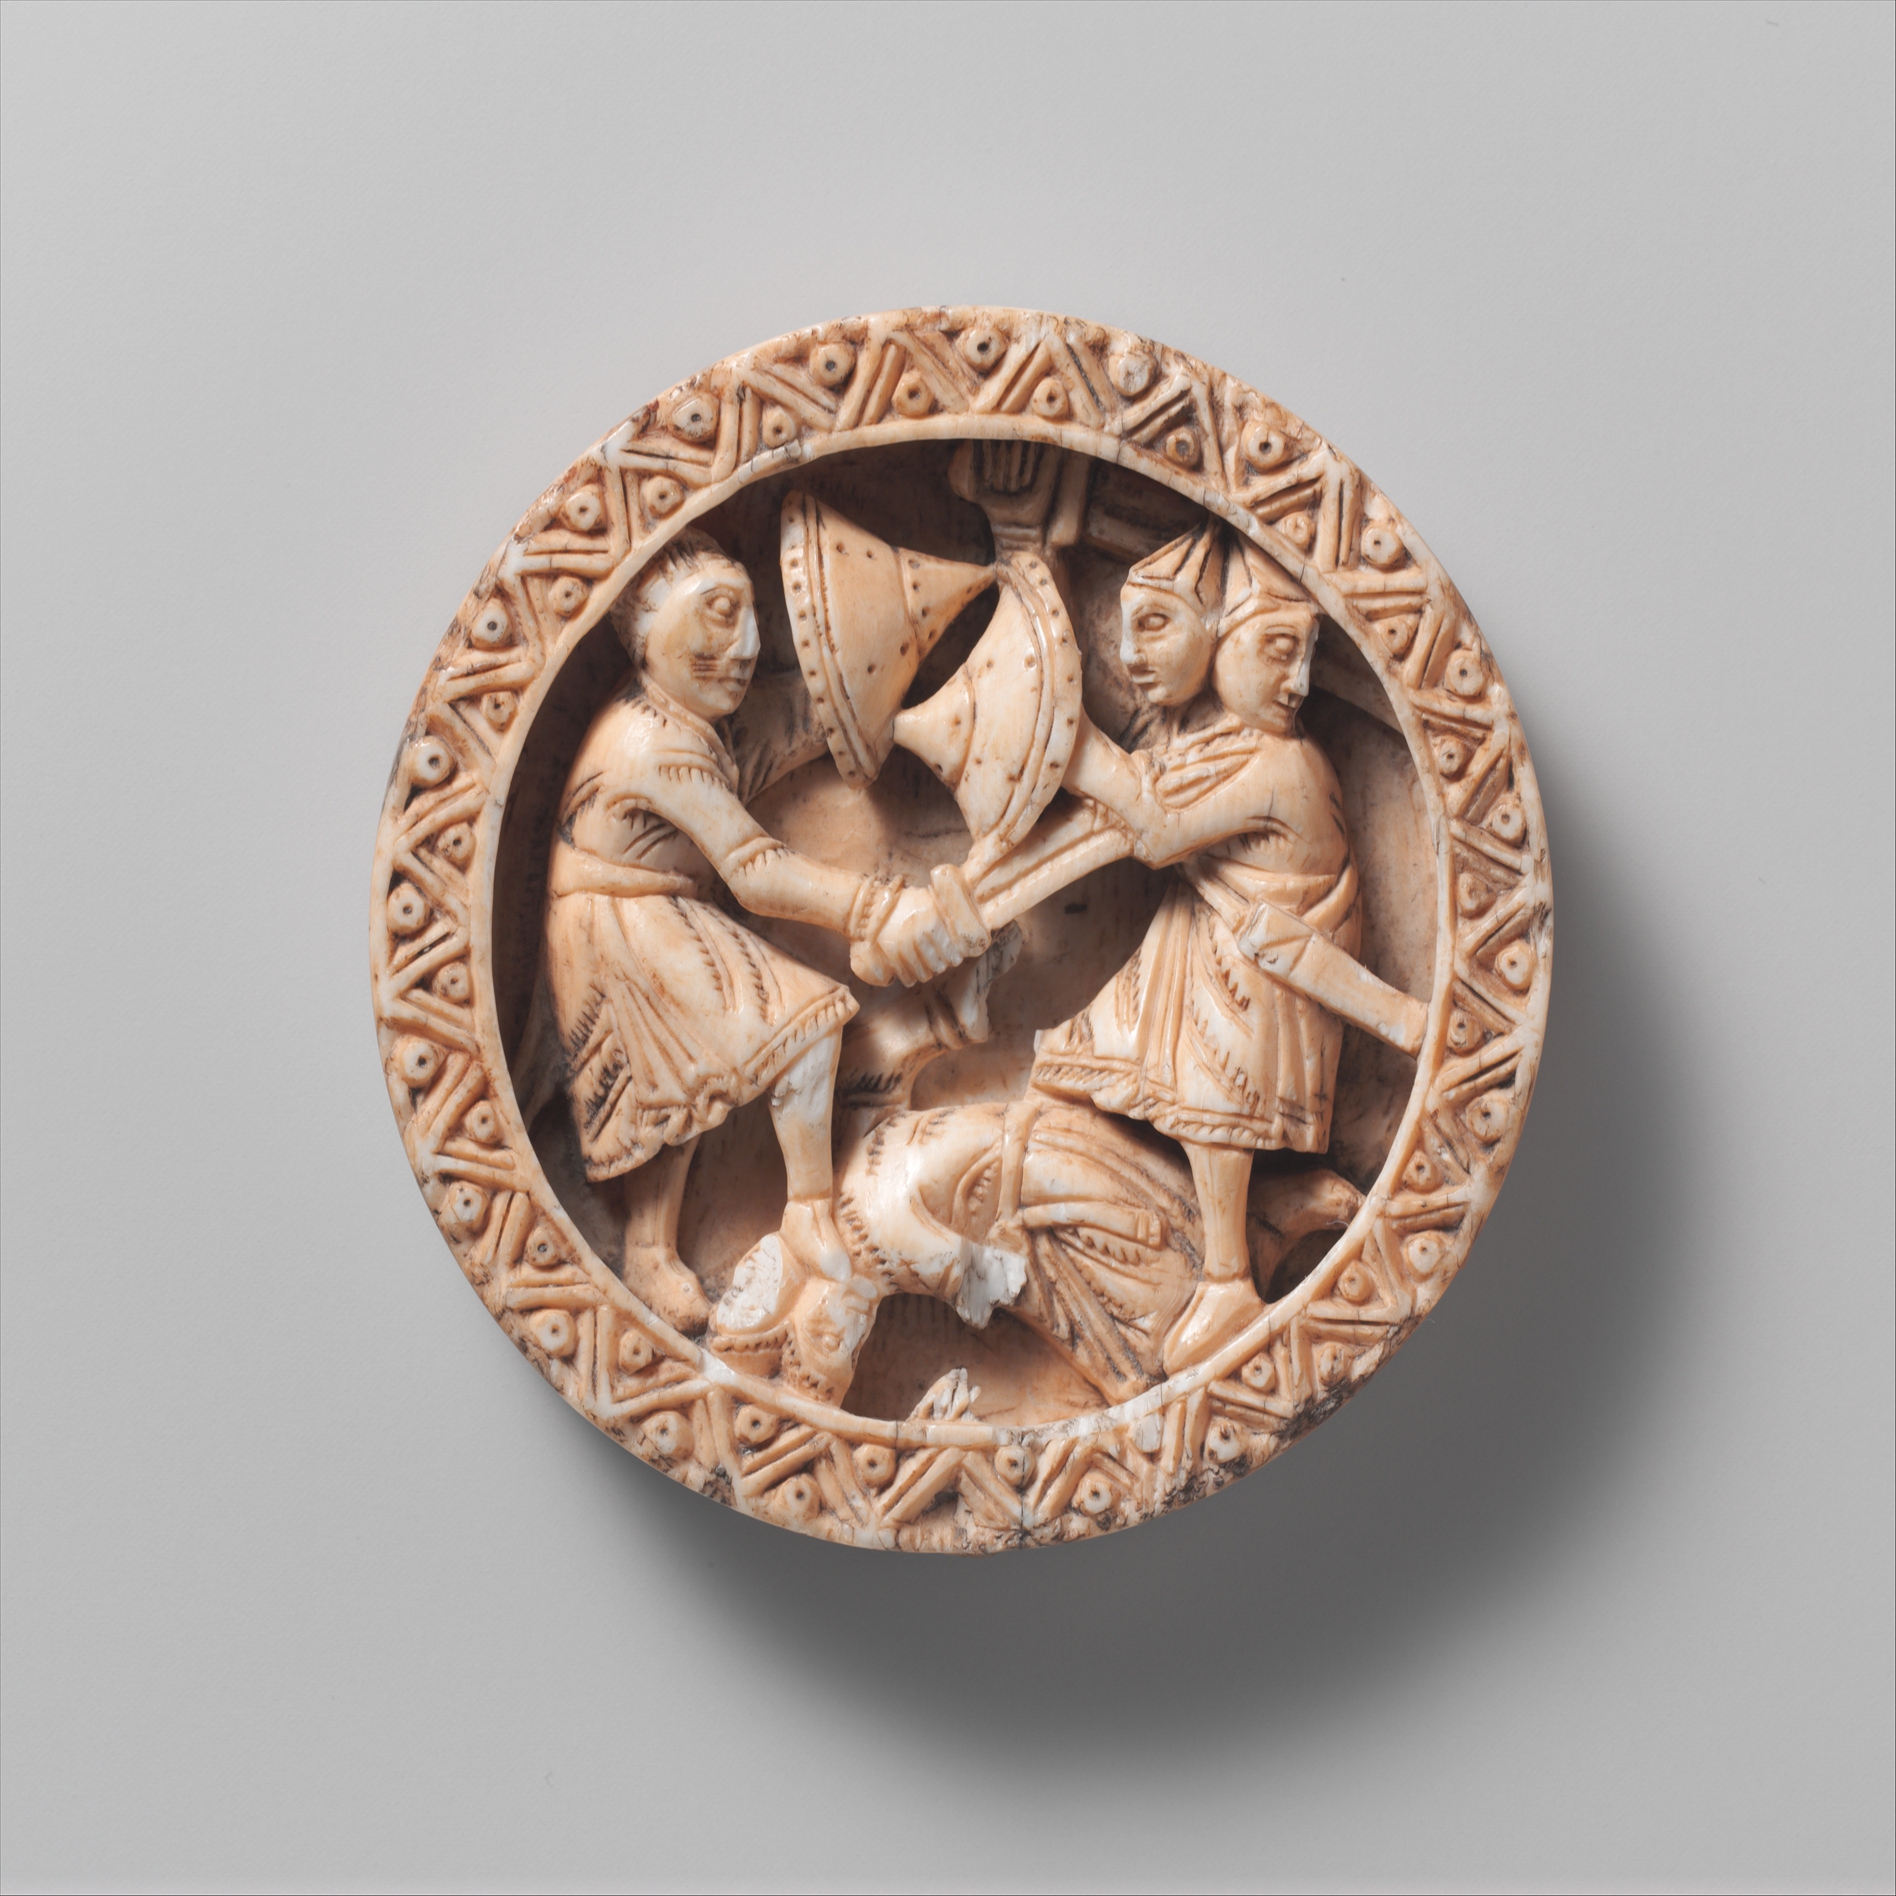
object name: game piece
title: Game Piece with Hercules Slaying the Three-Headed Geryon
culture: german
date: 1150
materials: ivory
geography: germany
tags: hercules,monsters,games